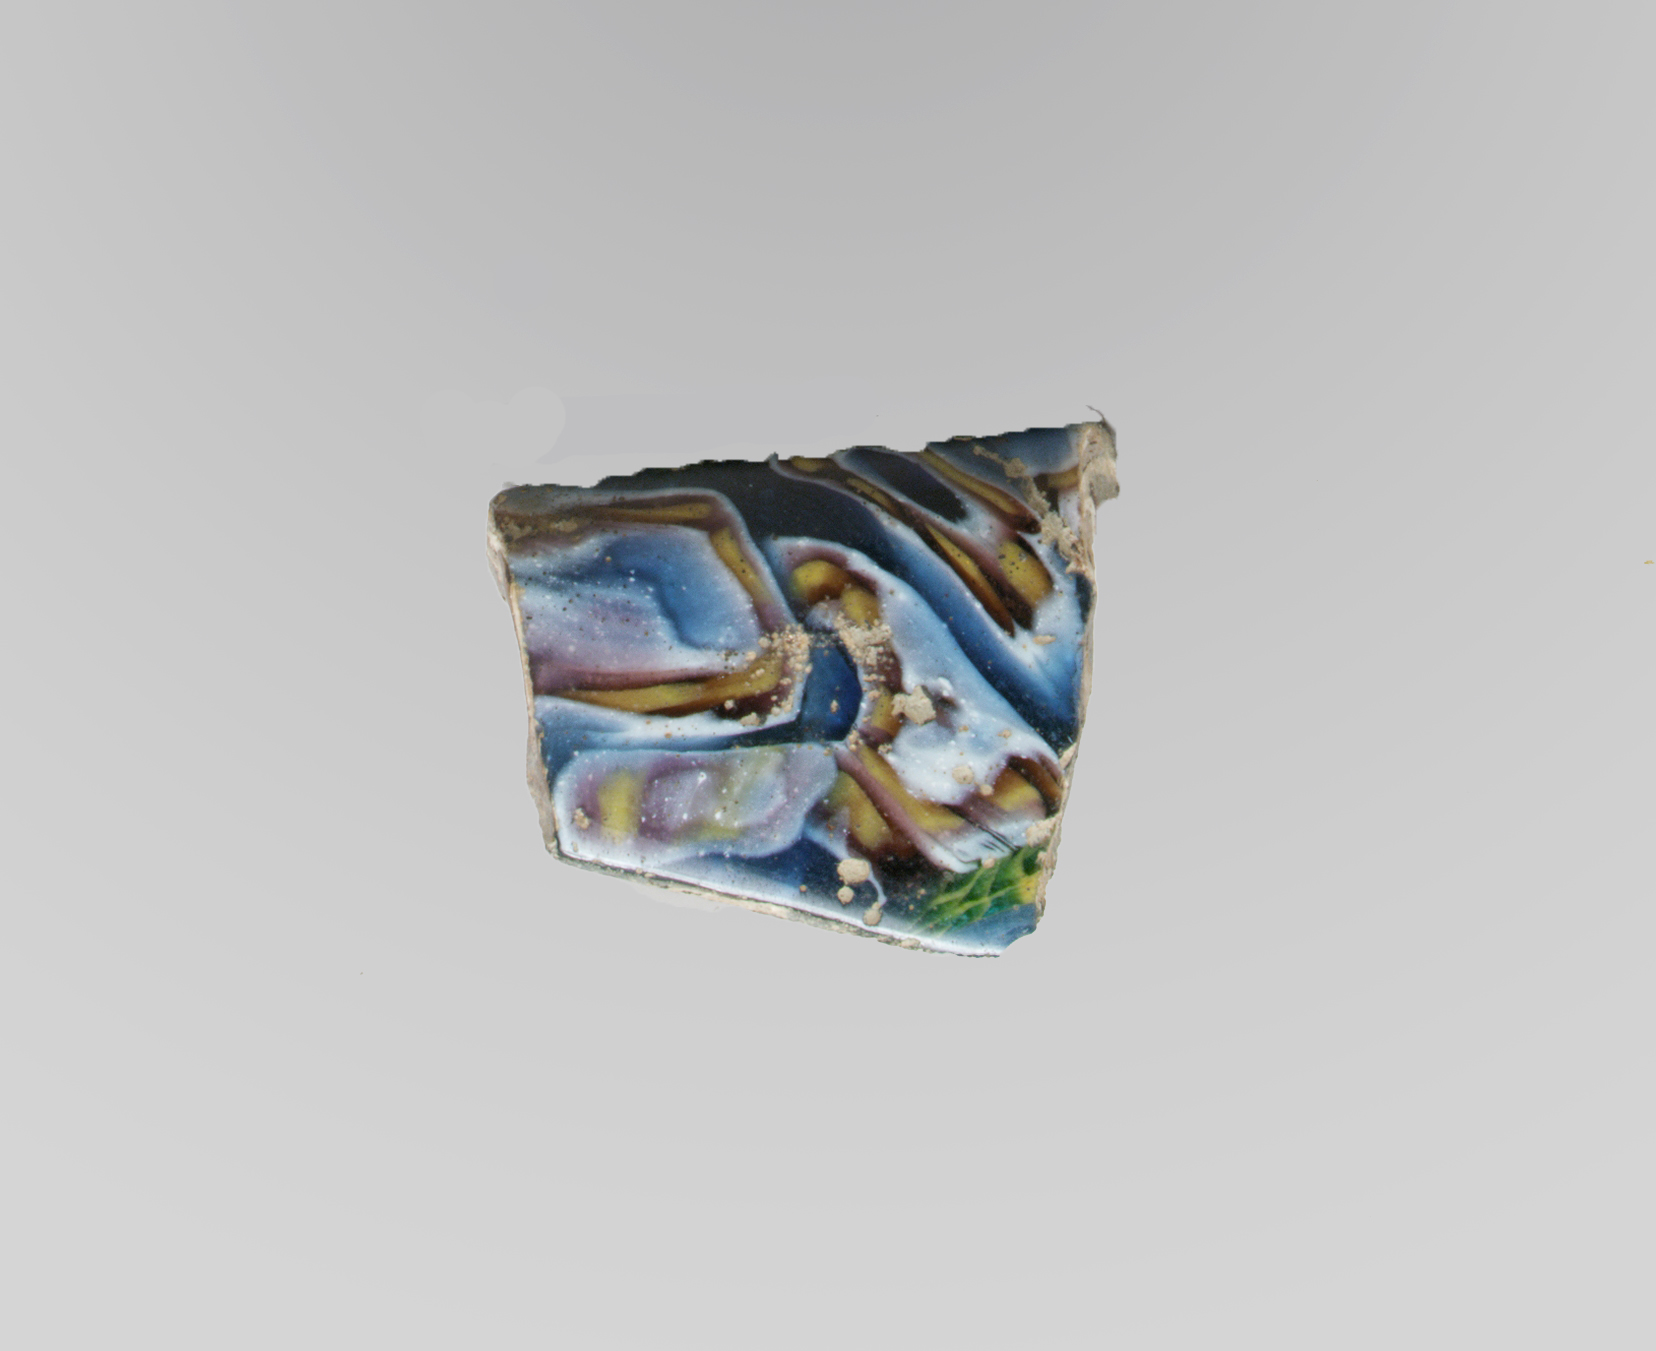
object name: fragment, mosaic bowl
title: Glass mosaic carinated bowl fragment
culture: roman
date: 34 BCE-33 CE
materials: glass